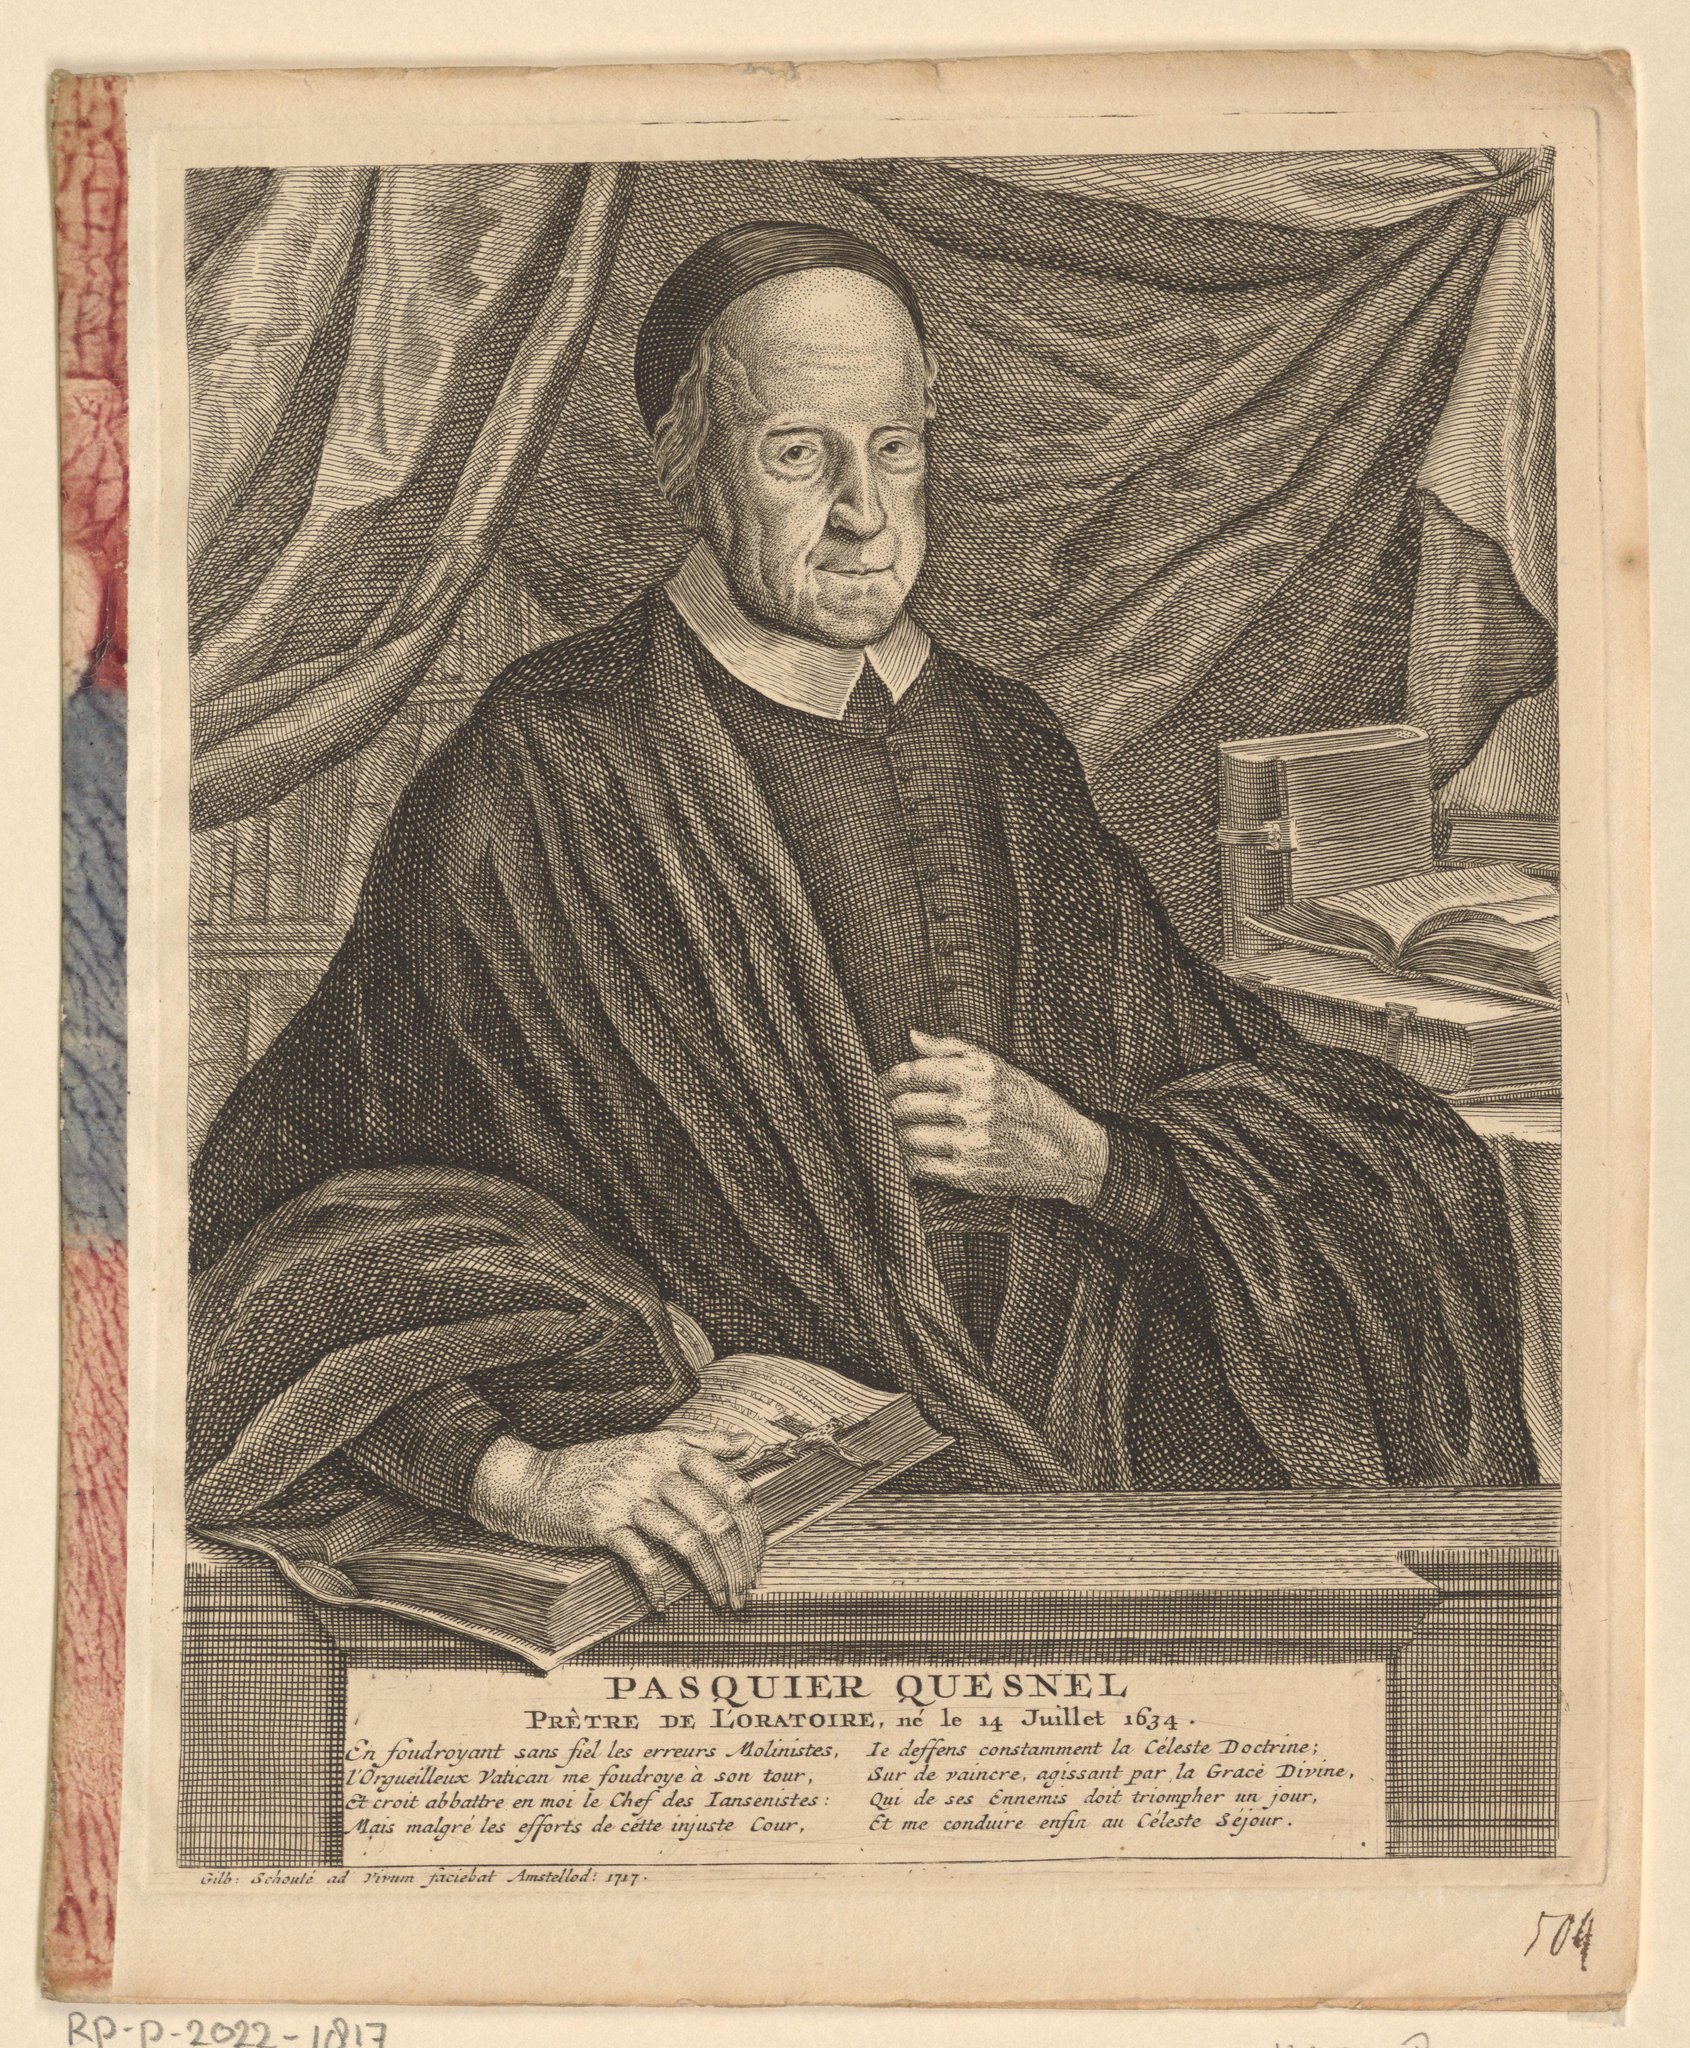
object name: print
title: Portret van Pasquier Quesnel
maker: gilbert schouten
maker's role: print maker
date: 1717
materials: paper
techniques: engraving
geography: amsterdam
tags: amsterdam, theologian, historical persons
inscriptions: number: ‘504’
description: Met achtregelig onderschrift in het Frans in twee kolommen.